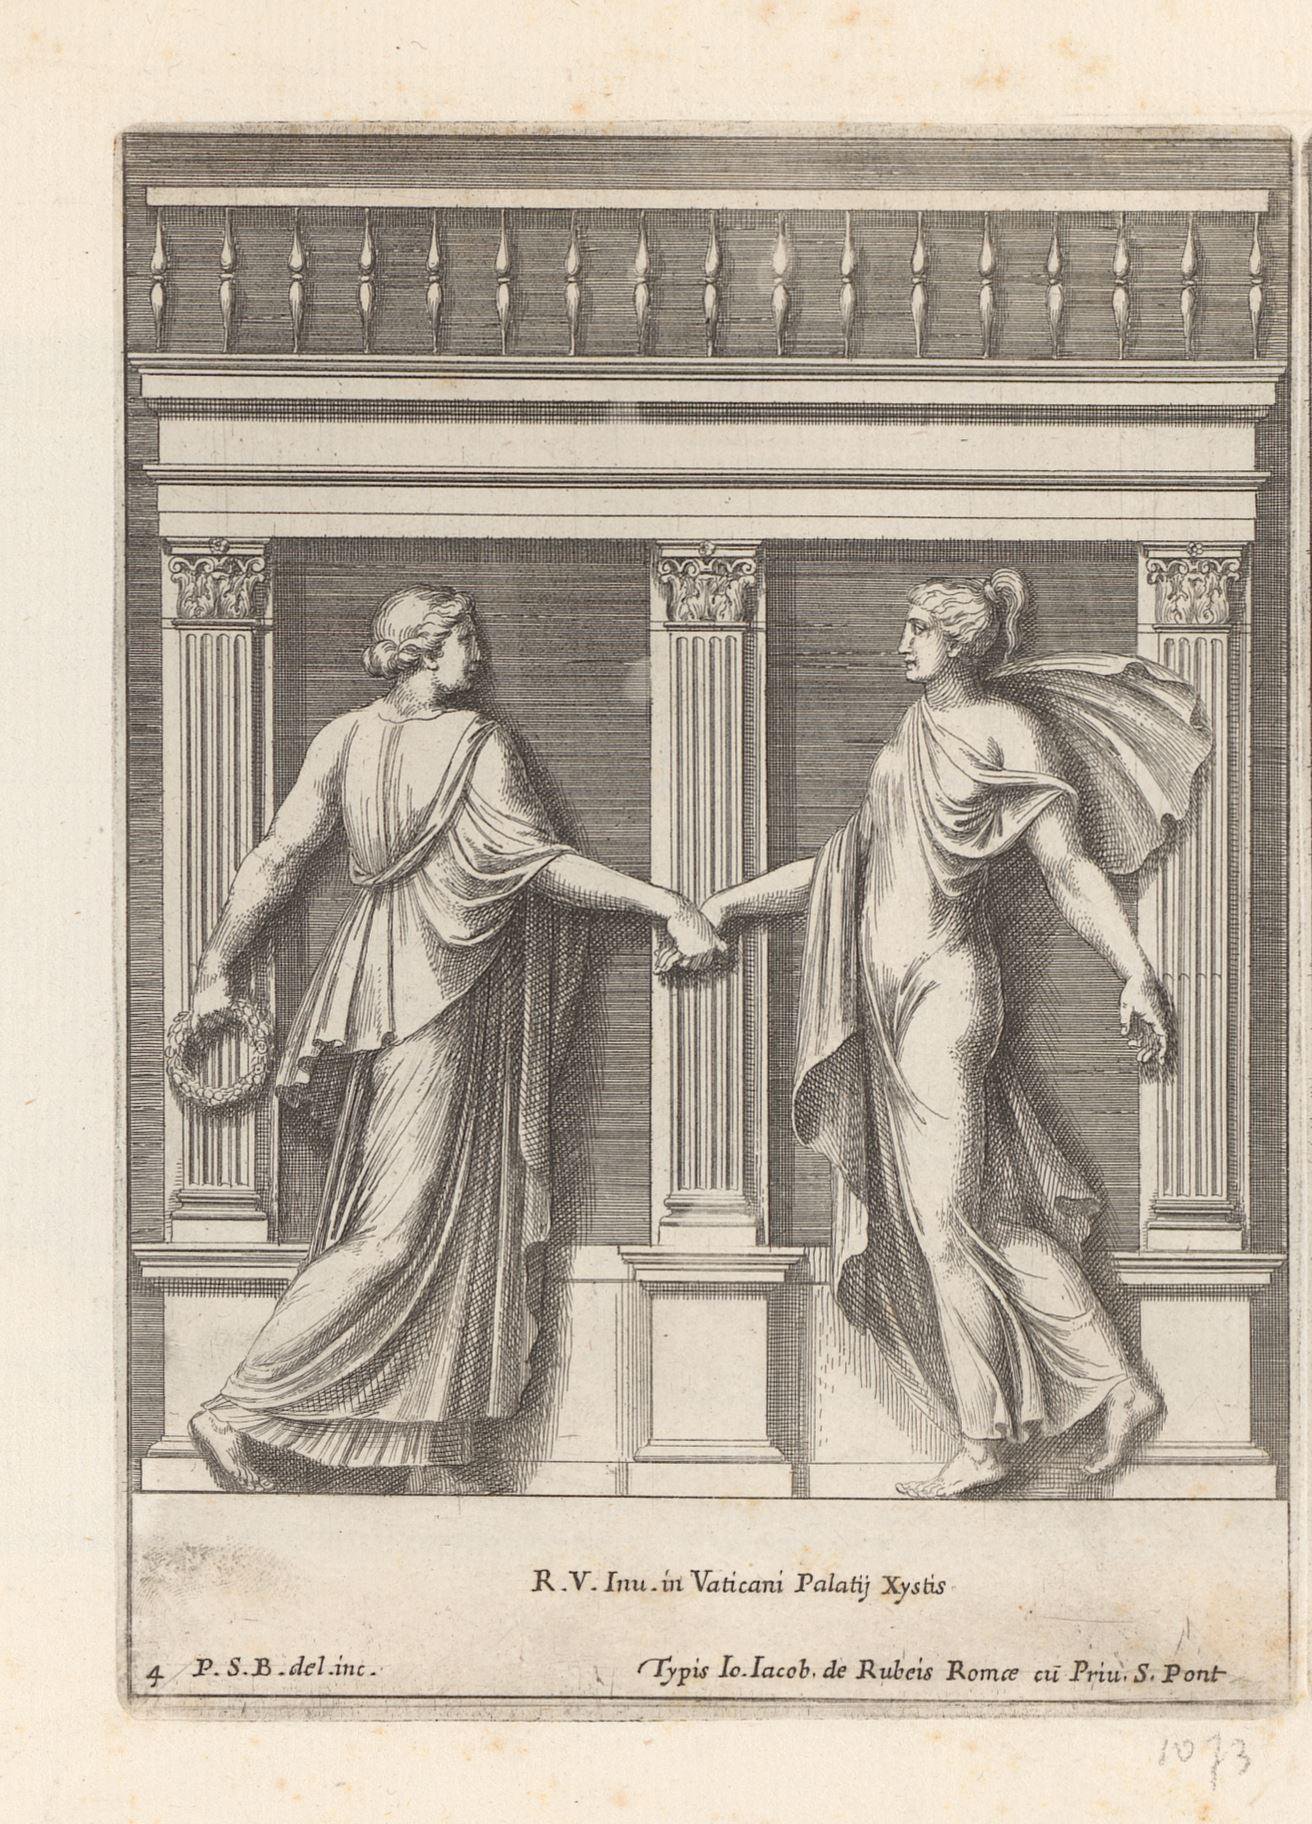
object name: print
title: Twee dansende figuren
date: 1645-1700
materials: paper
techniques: engraving, etching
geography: italy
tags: adult woman, dancing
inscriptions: number: ‘38’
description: Twee dansende vrouwenfiguren voor een balustrade en drie pilasters. Een houdt een krans in haar hand. Prent maakt deel uit van een album.